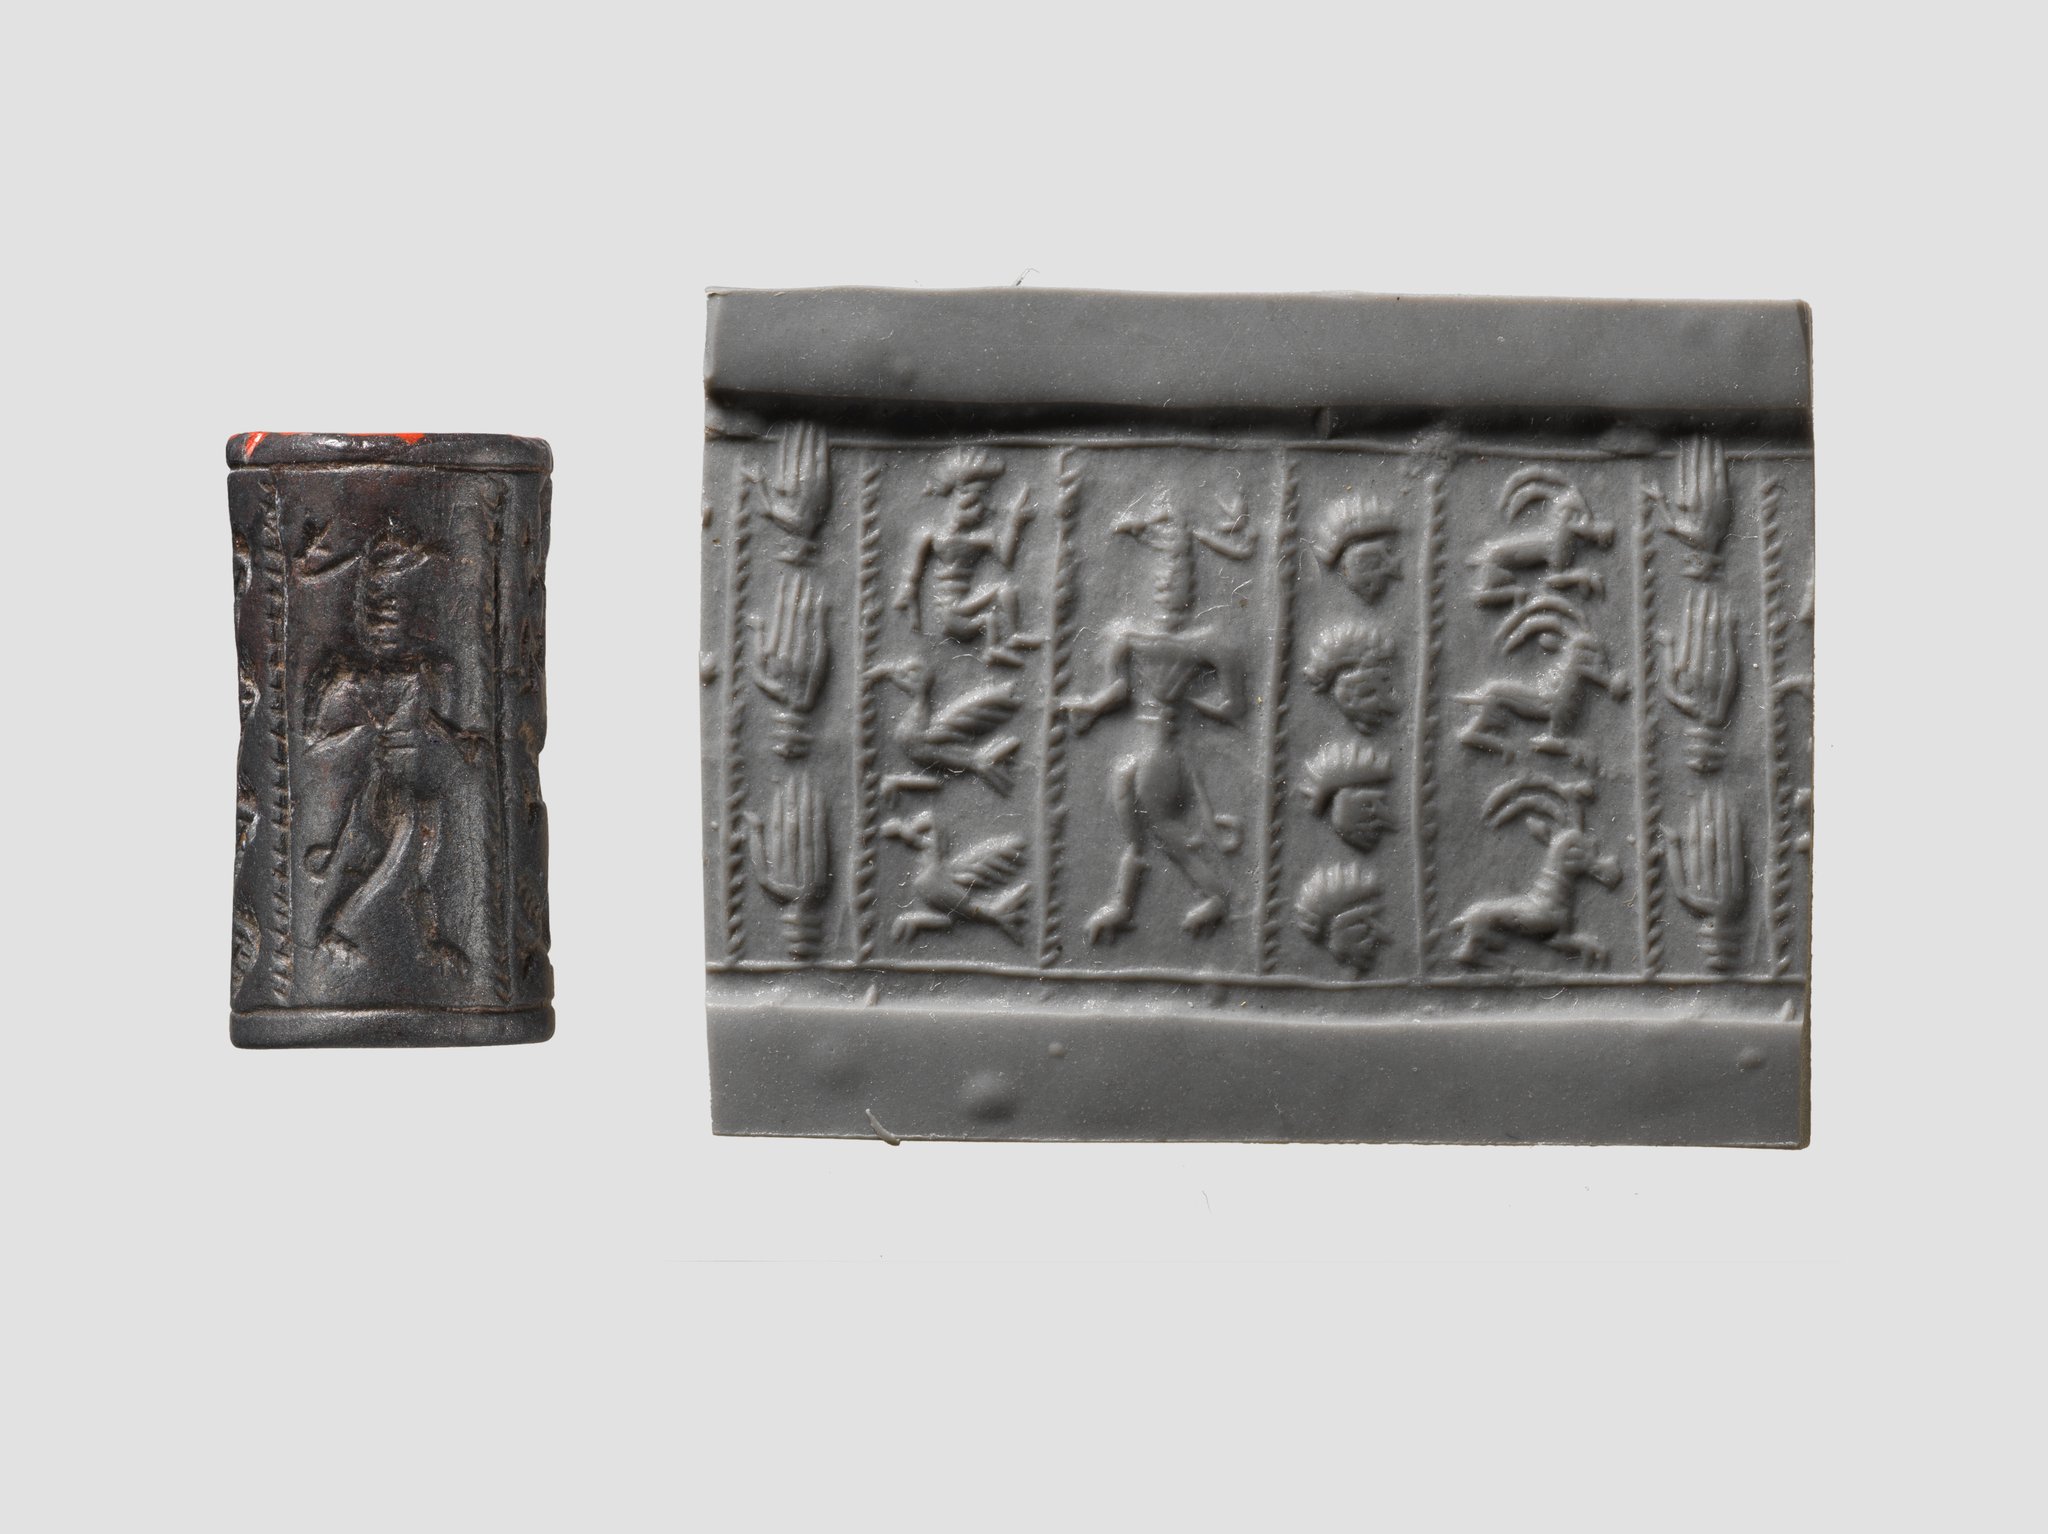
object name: cylinder seal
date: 1820-1730 BCE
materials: mineral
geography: syria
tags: birds,hands,heads,ibex